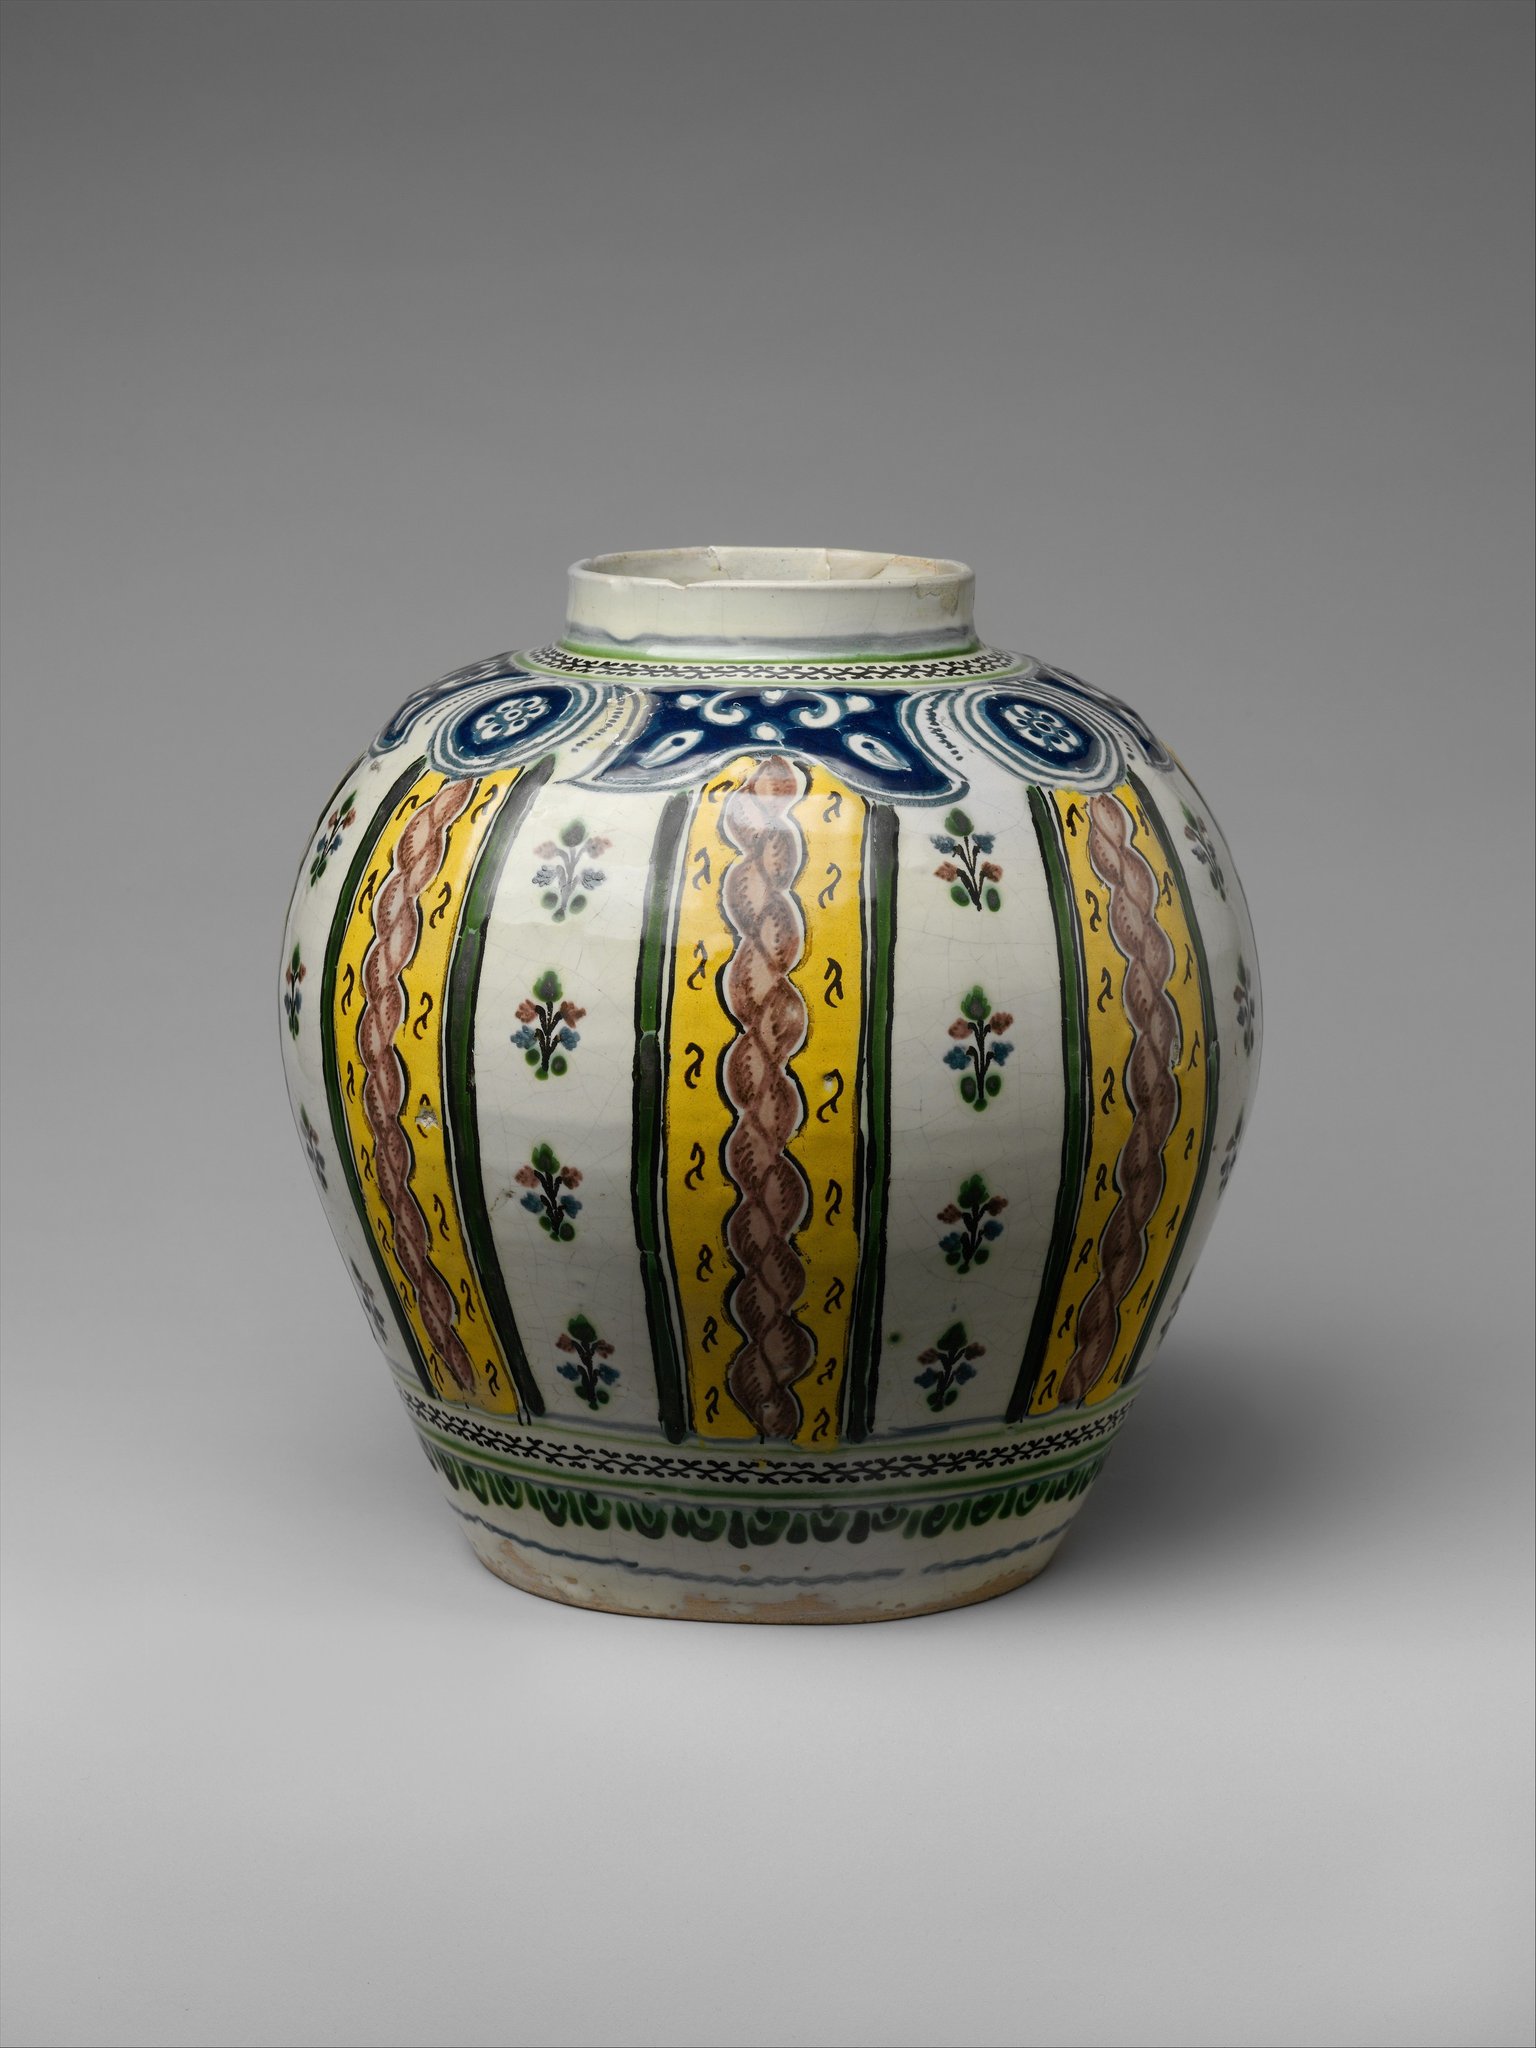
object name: jar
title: Globular Jar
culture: mexican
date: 1800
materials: earthenware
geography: mexico